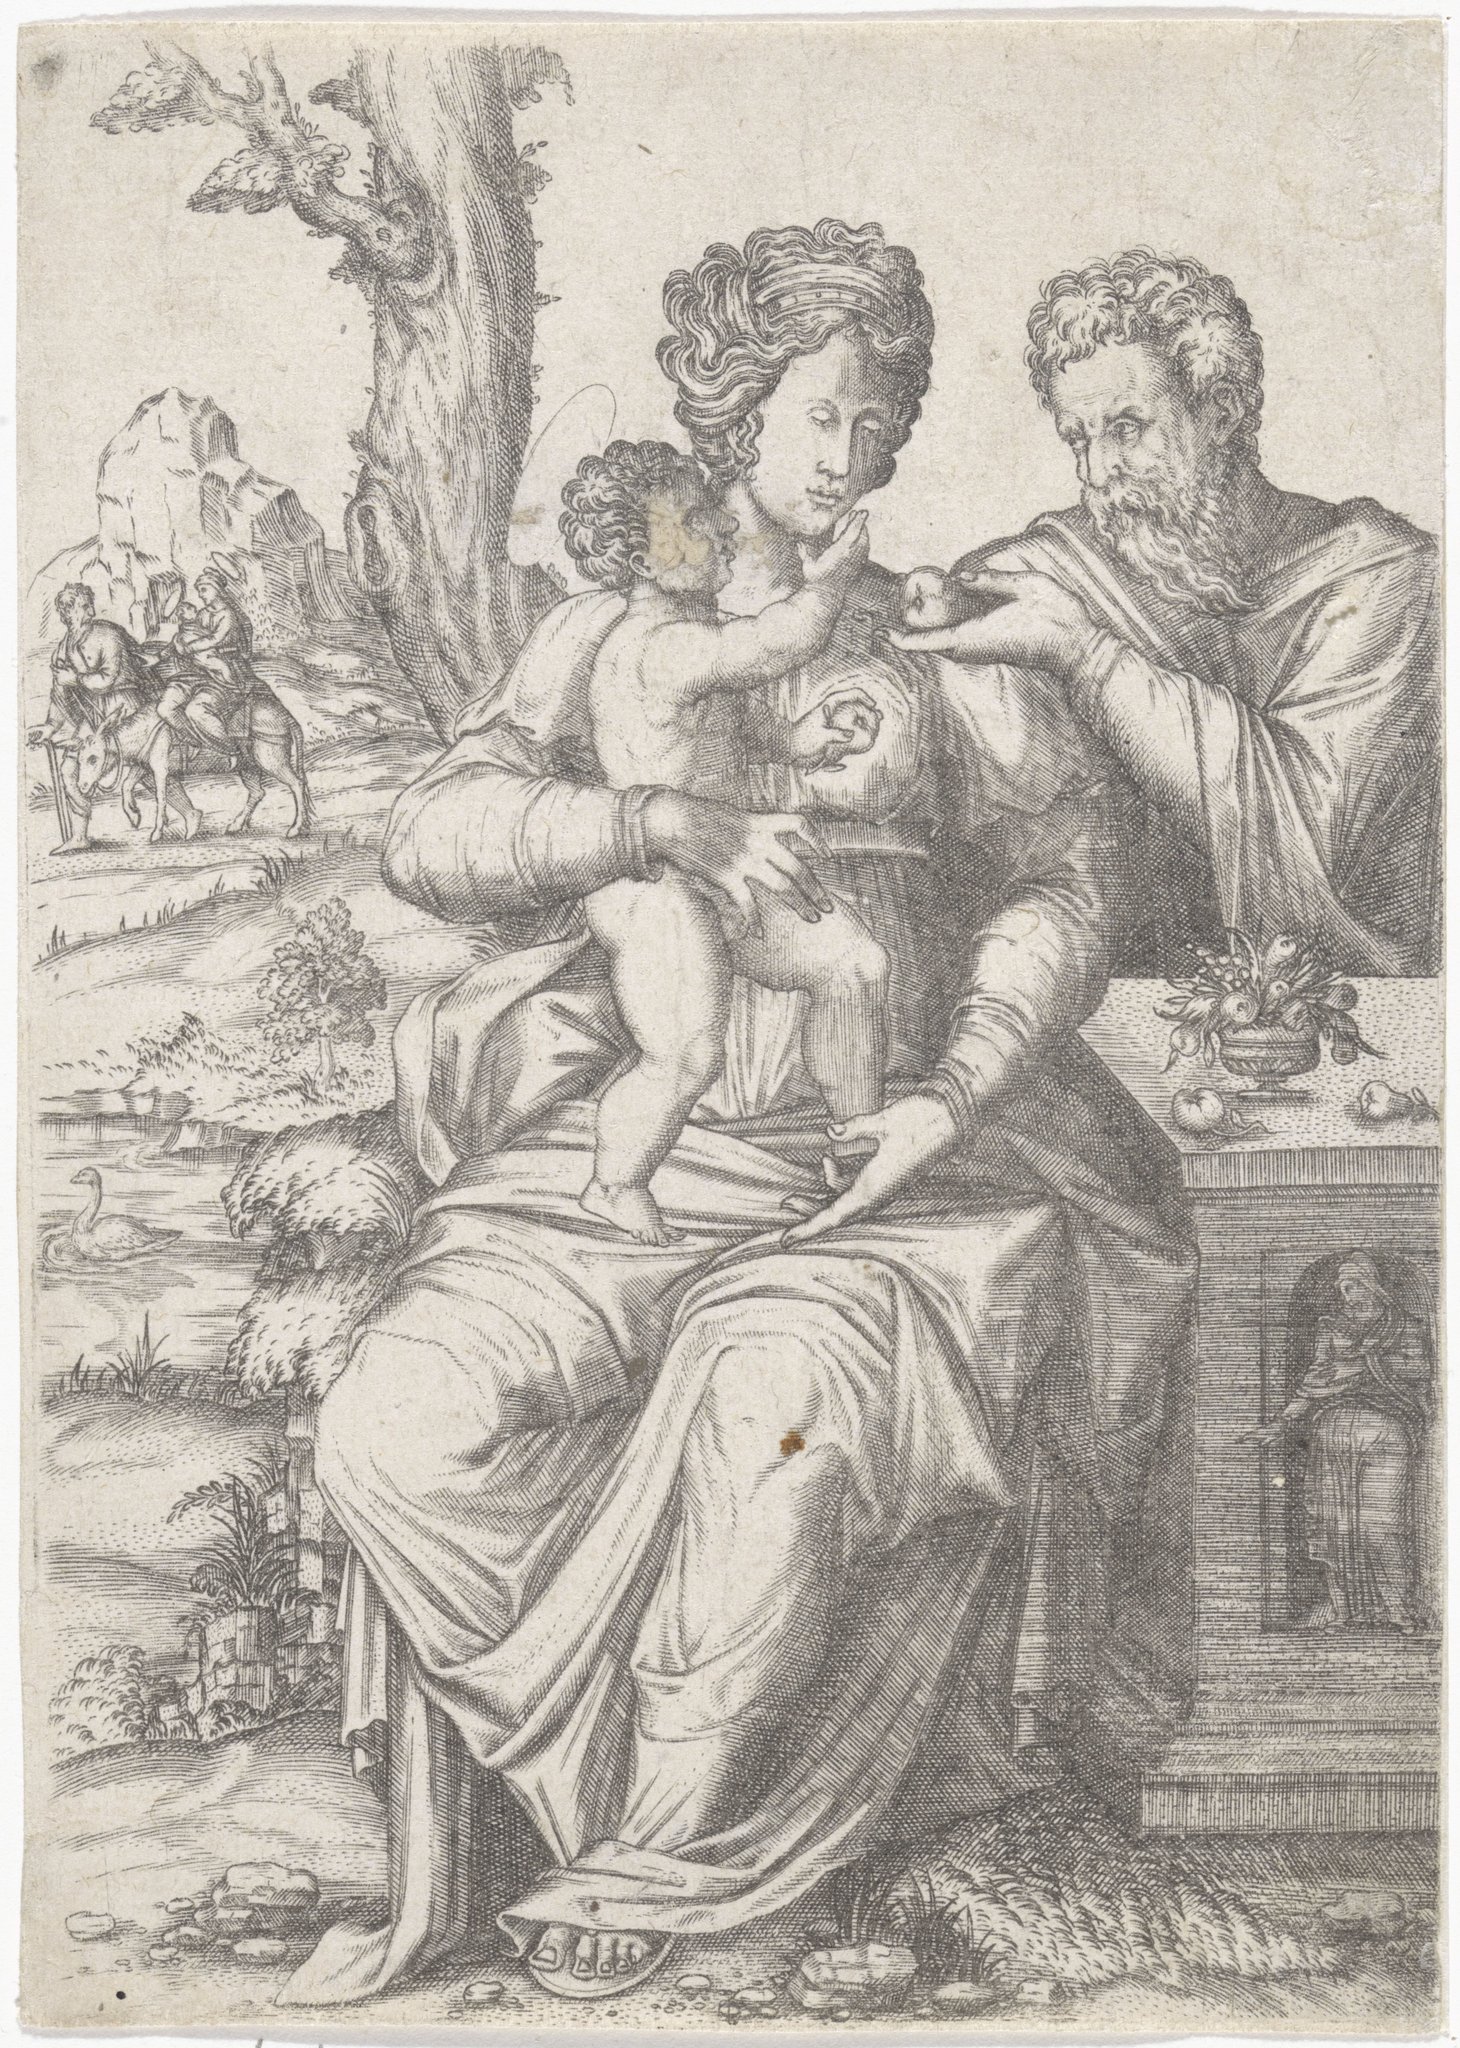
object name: print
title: Rest on the Flight into Egypt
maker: lambertus suavius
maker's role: print maker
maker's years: 1514-1564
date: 1520-1567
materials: paper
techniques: engraving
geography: southern netherlands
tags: the flight into egypt: mary, joseph, the child (and sometimes others) on their way; mary usually riding on an ass, rest on the flight into egypt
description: Maria, met het Christuskind op schoot, en Jozef rusten uit bij een monument. Jozef geeft Christus een vrucht. Op de achtergrond de Heilige Familie onderweg.